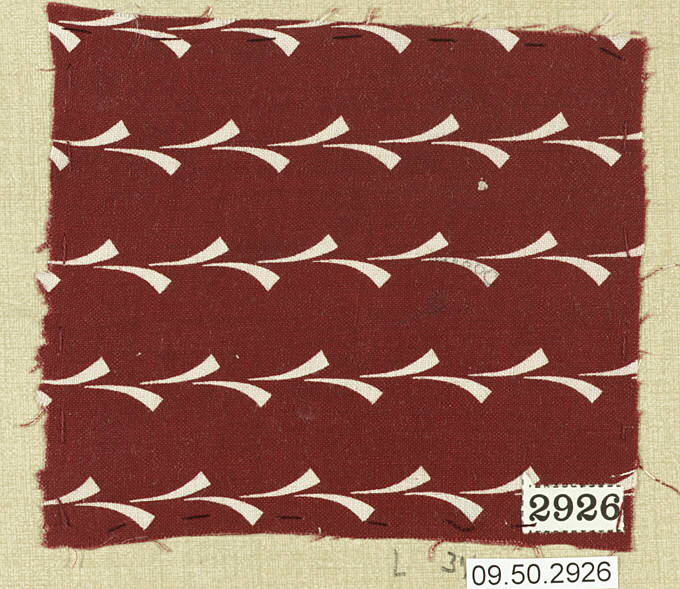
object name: piece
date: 1801-1900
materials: cotton